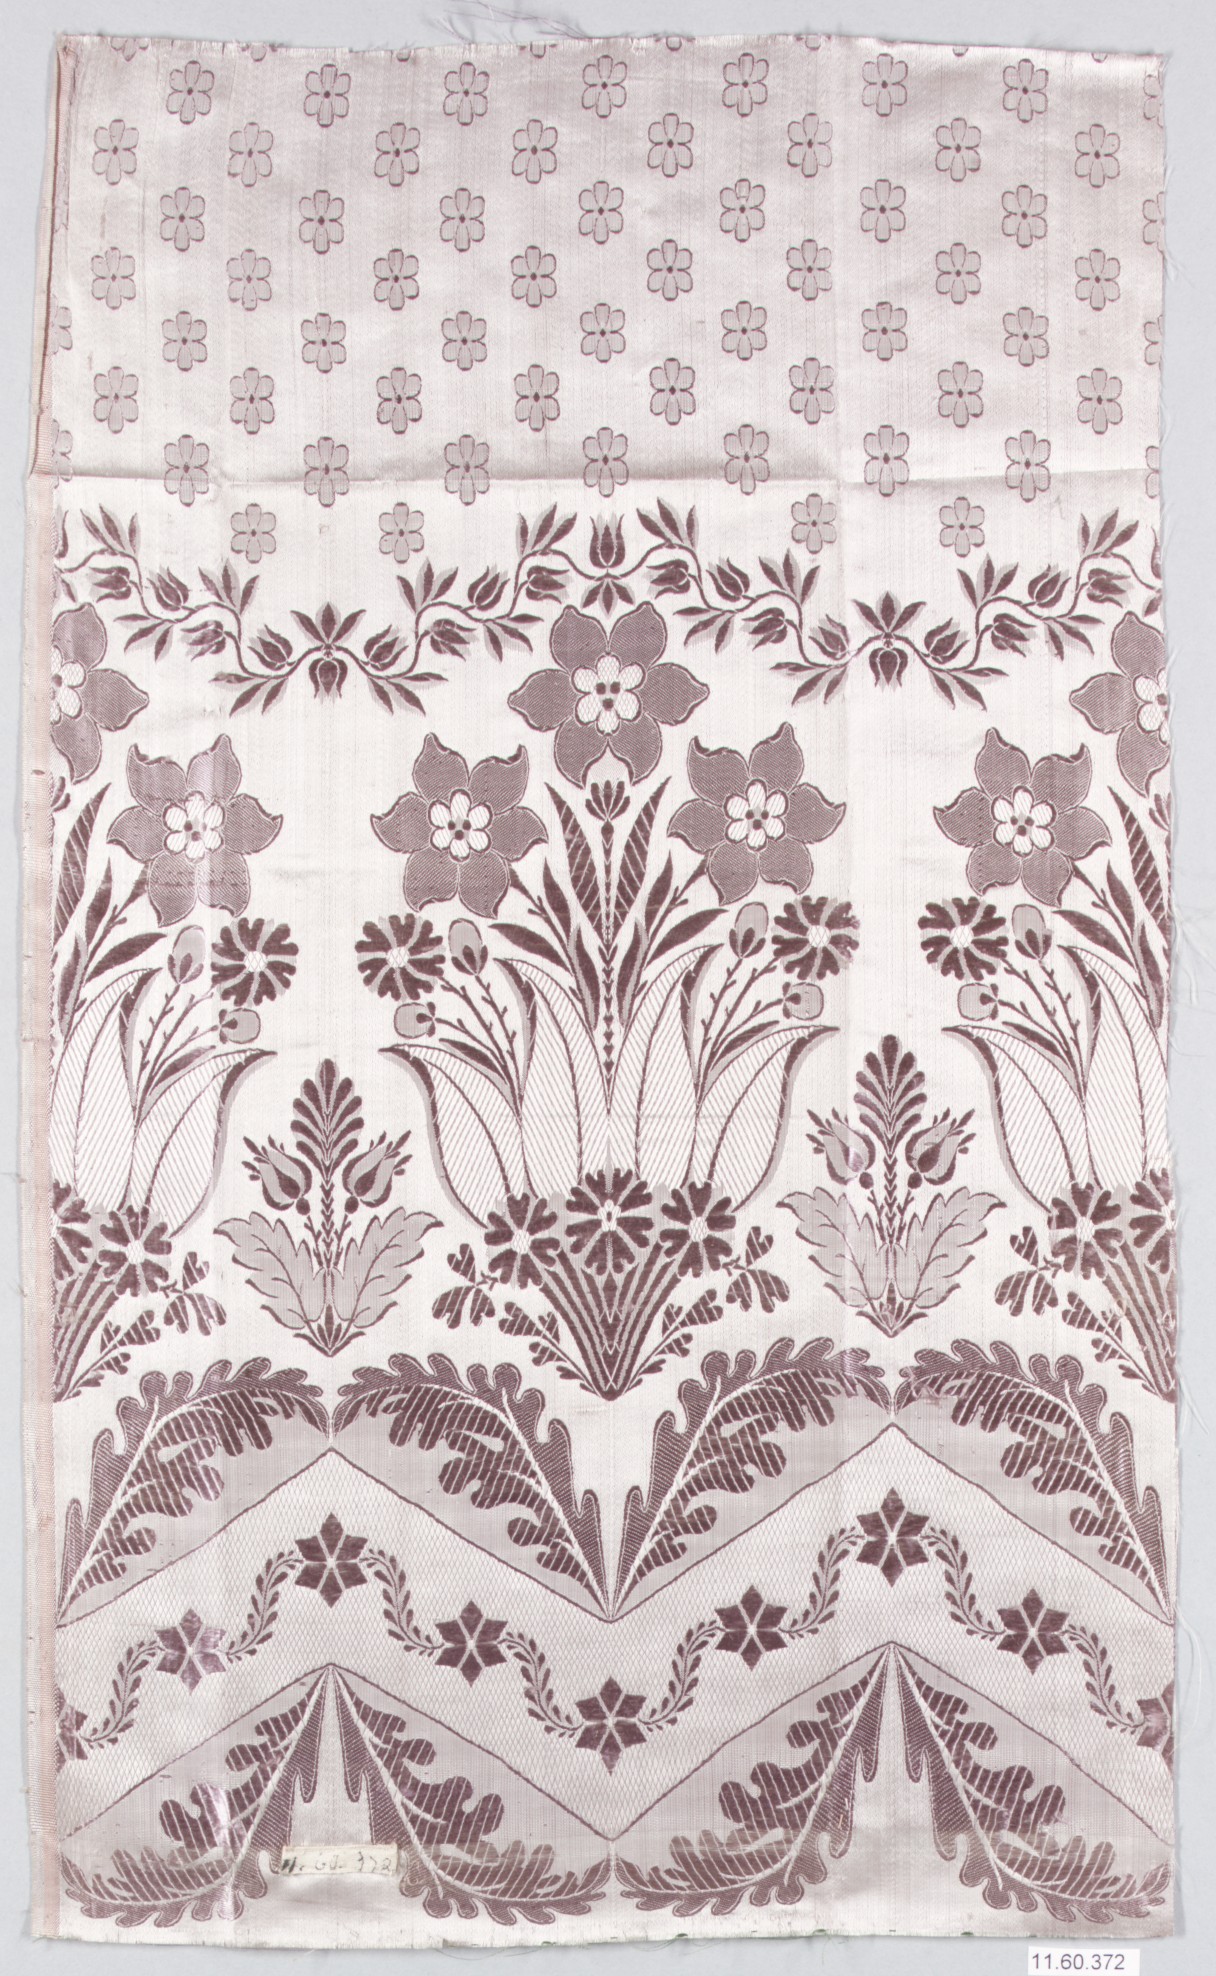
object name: fragment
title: Fragments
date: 1801-1900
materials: silk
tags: flowers,leaves